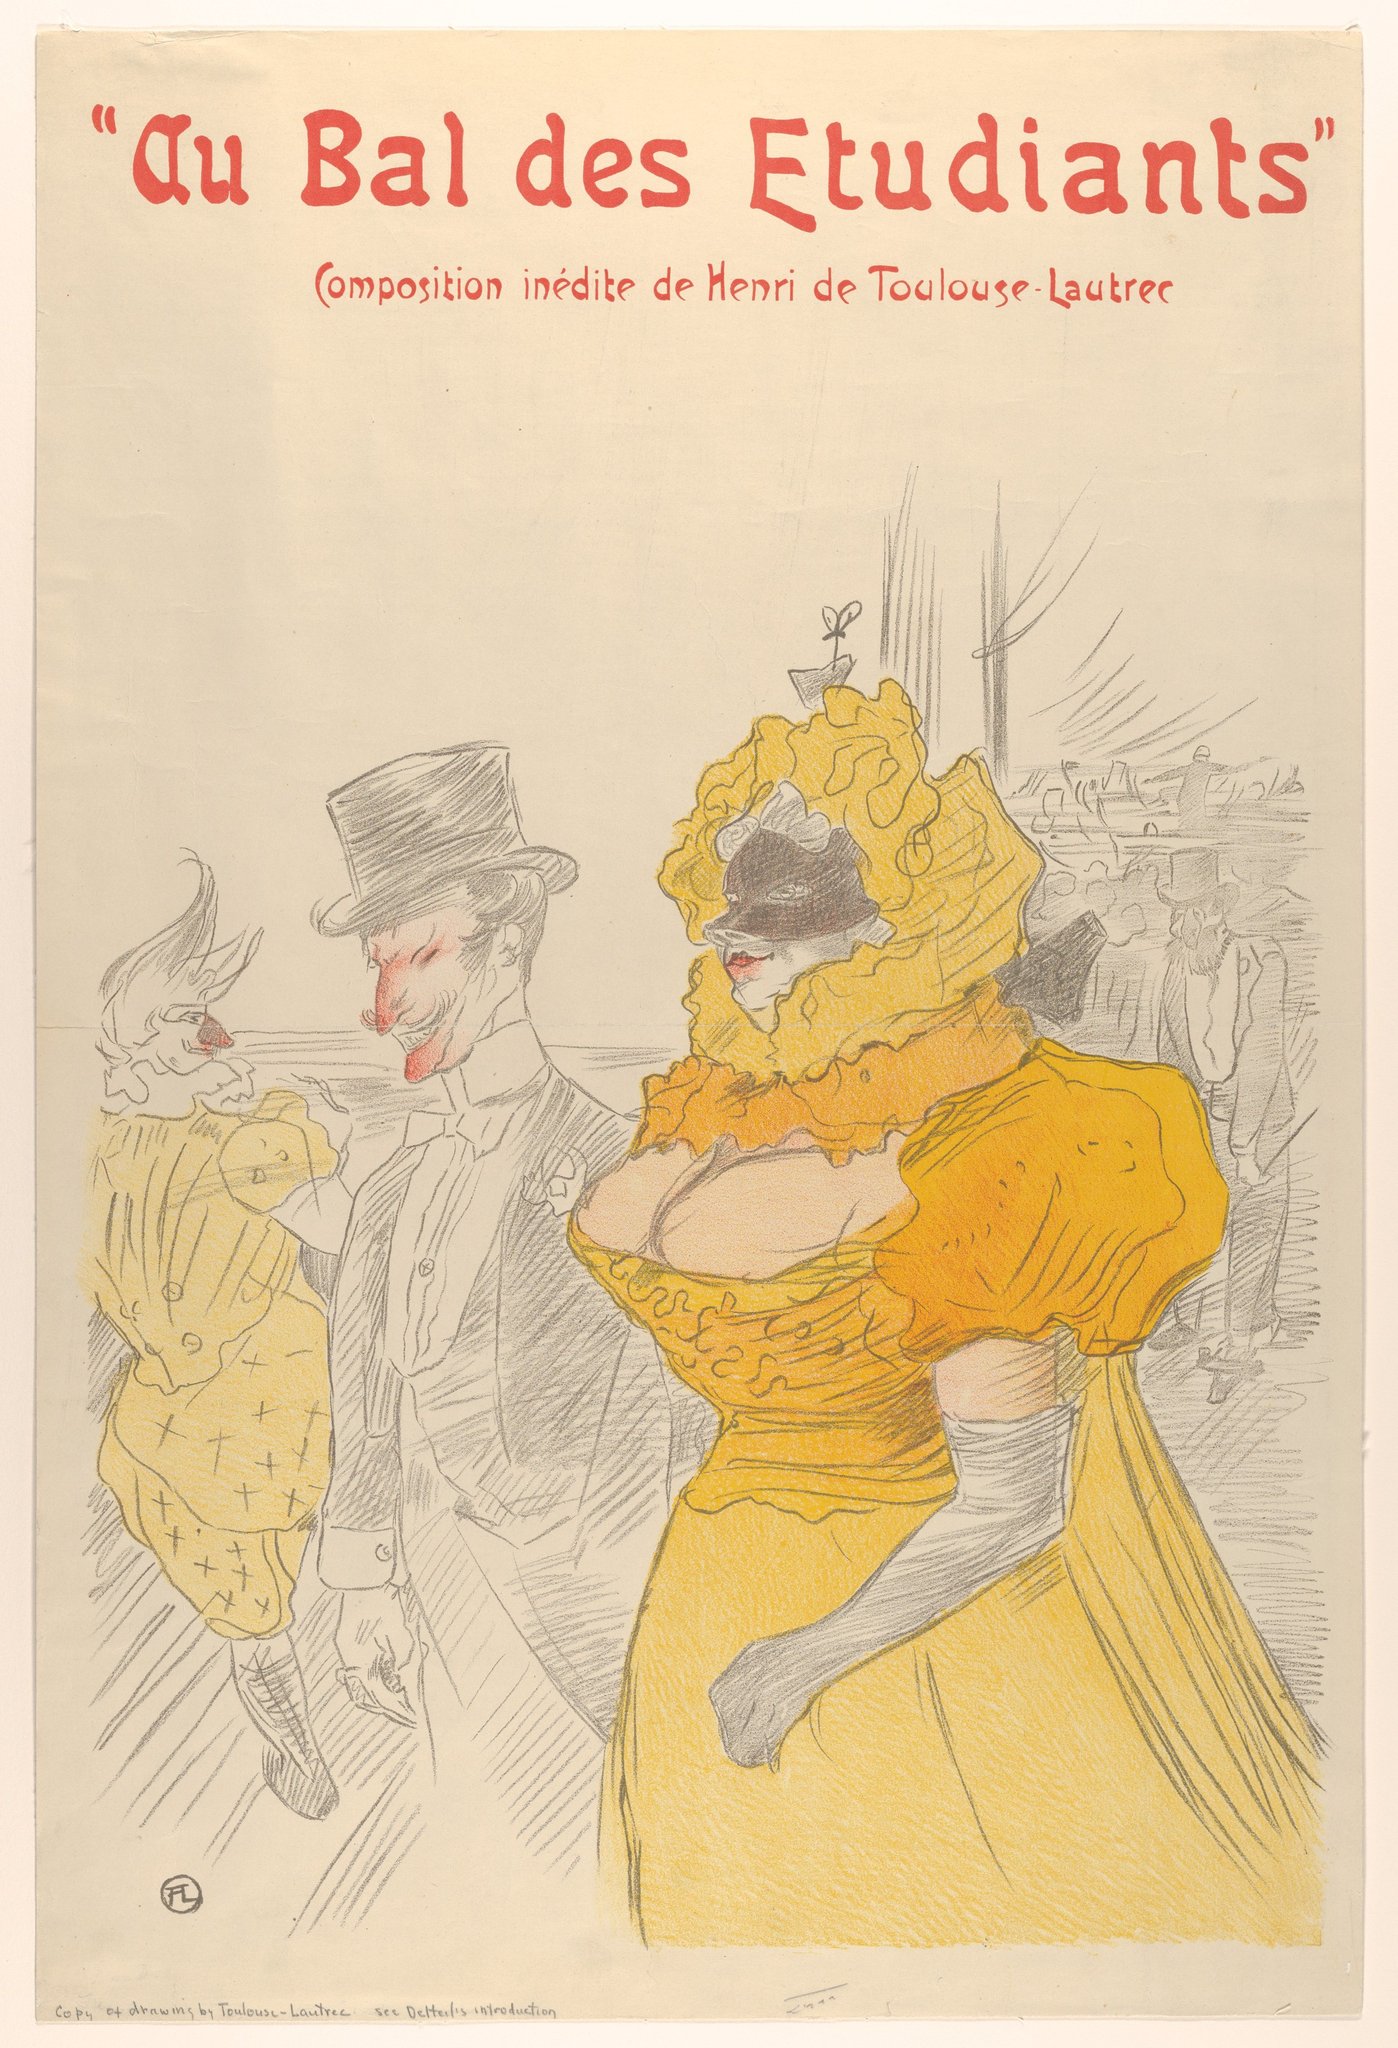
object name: print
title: Au Bal des Etudiants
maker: henri de toulouse-lautrec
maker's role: artist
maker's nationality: french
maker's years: 1864-1901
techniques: drawing, photography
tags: masks,hats,men,women